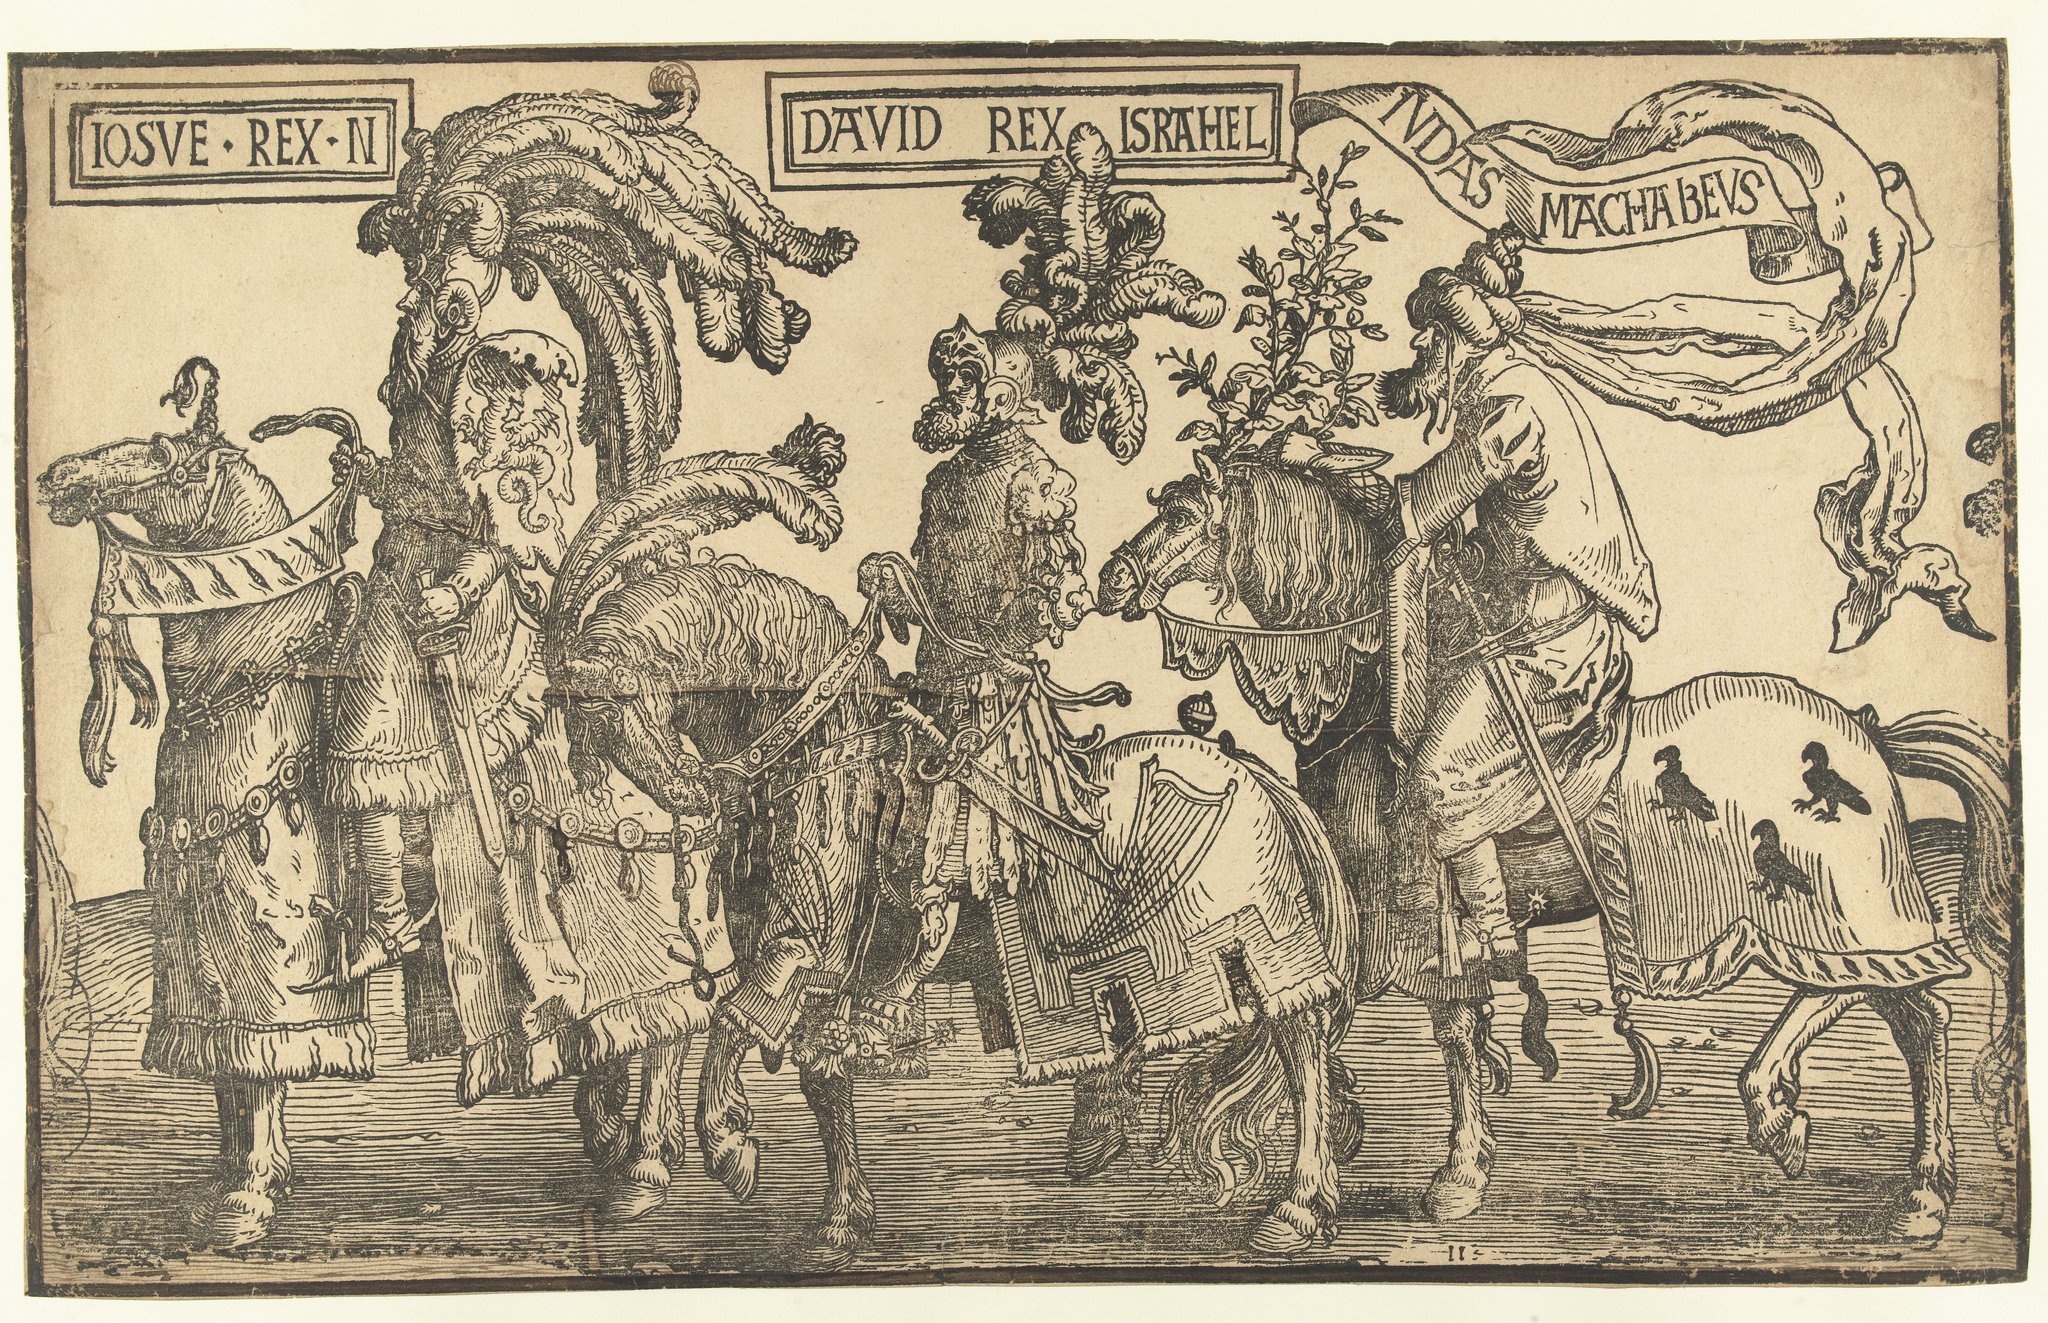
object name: print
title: De helden Jozua, David en Judas de Makkabeeër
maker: lucas van leyden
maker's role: draughtsman, painter, print maker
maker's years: 1494-1533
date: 1518-1522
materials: paper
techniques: woodcut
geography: low countries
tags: judas maccabaeus (one of the nine worthies), david (one of the nine worthies), joshua (one of the nine worthies)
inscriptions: collector's mark: Lugt 240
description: Eén van drie houtsneden, onderdeel van fries met negen helden. Drie Joodse helden: koning Jozua, koning David en Judas de Makkabeeër te paard. Boven alle drie een kader met naam en toenaam.